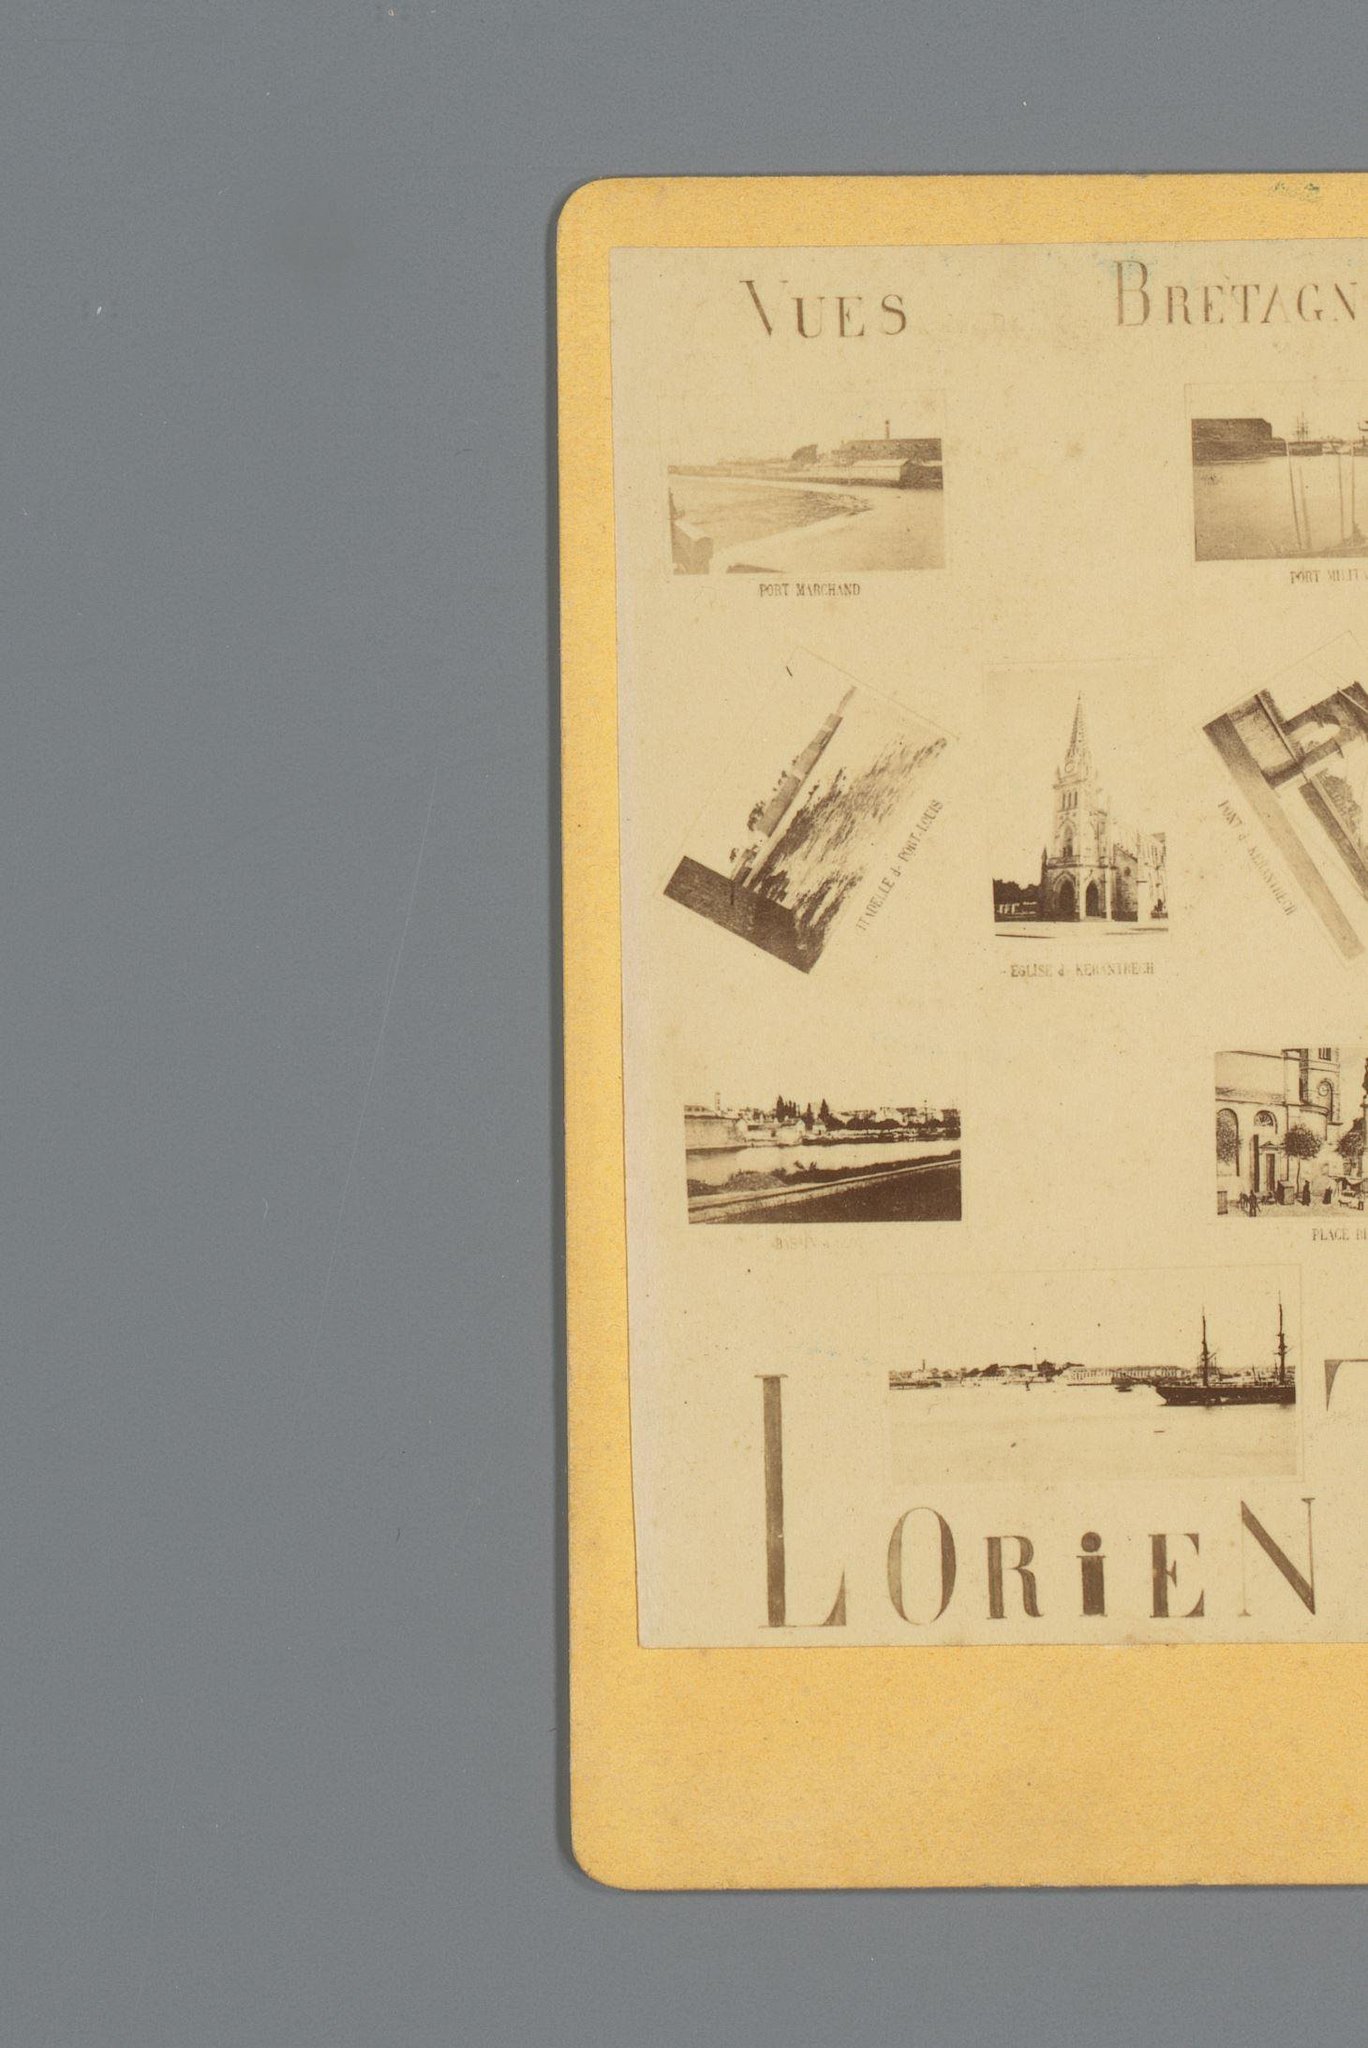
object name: photocollage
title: Gezichten op Lorient, Frankrijk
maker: ferdinand carlier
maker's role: fotograaf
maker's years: 1829-1892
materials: cardboard, paper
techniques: albumen print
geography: lorient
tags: city-view in general; 'veduta'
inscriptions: date: ‘14 septembre 1879’